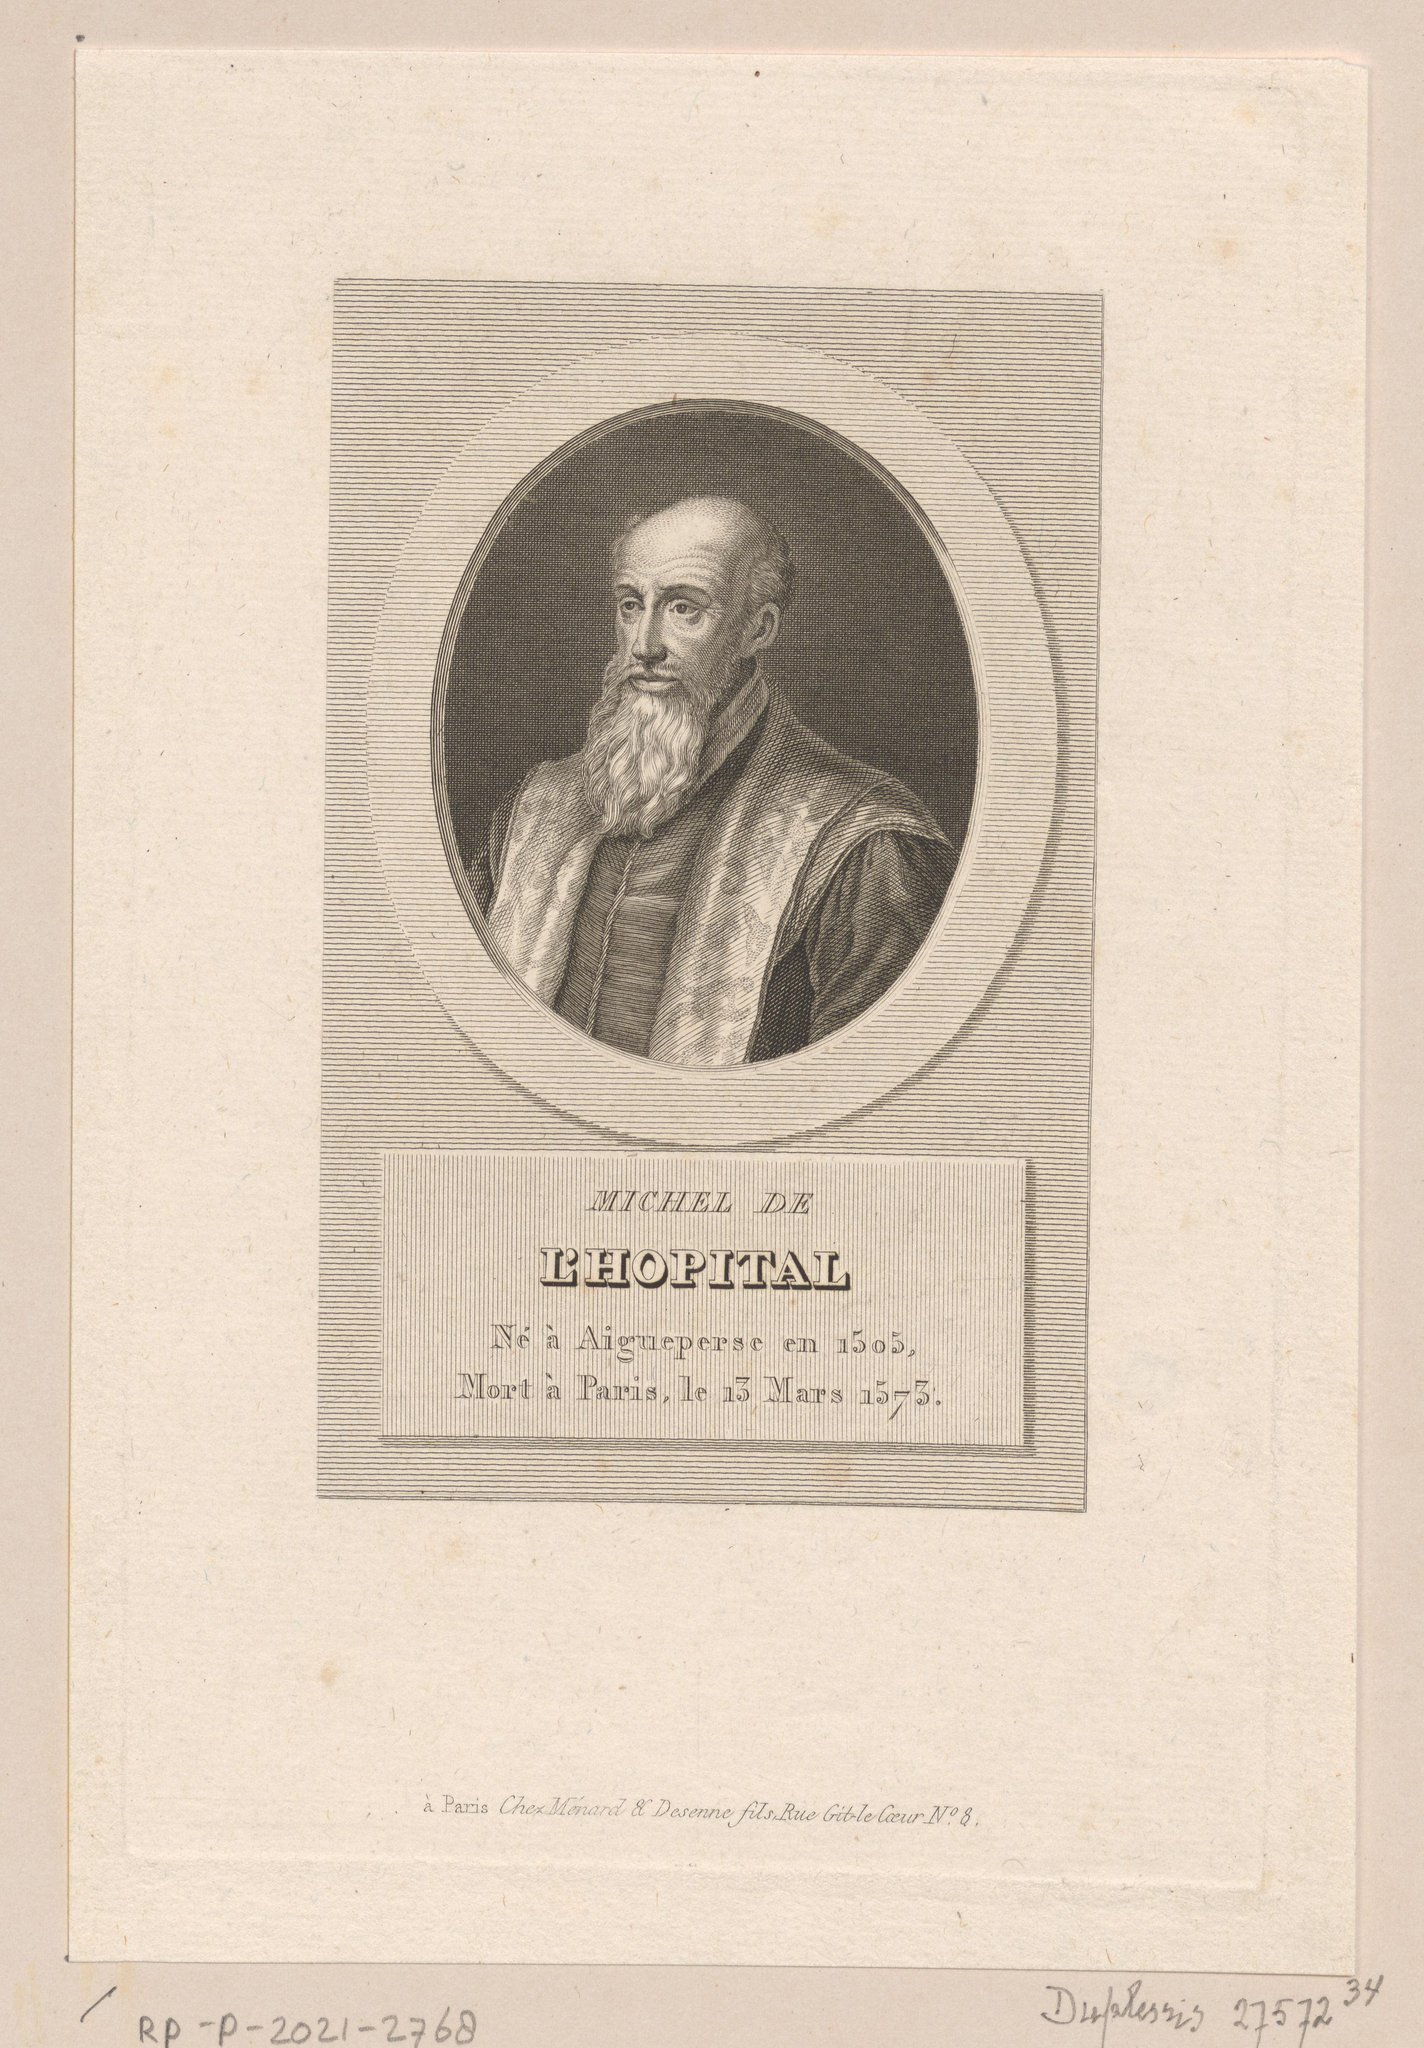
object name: print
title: Portret van Michel de L'Hospital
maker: Anonymous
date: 1816-1831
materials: paper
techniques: engraving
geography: paris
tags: ornament ~ medallion, historical persons